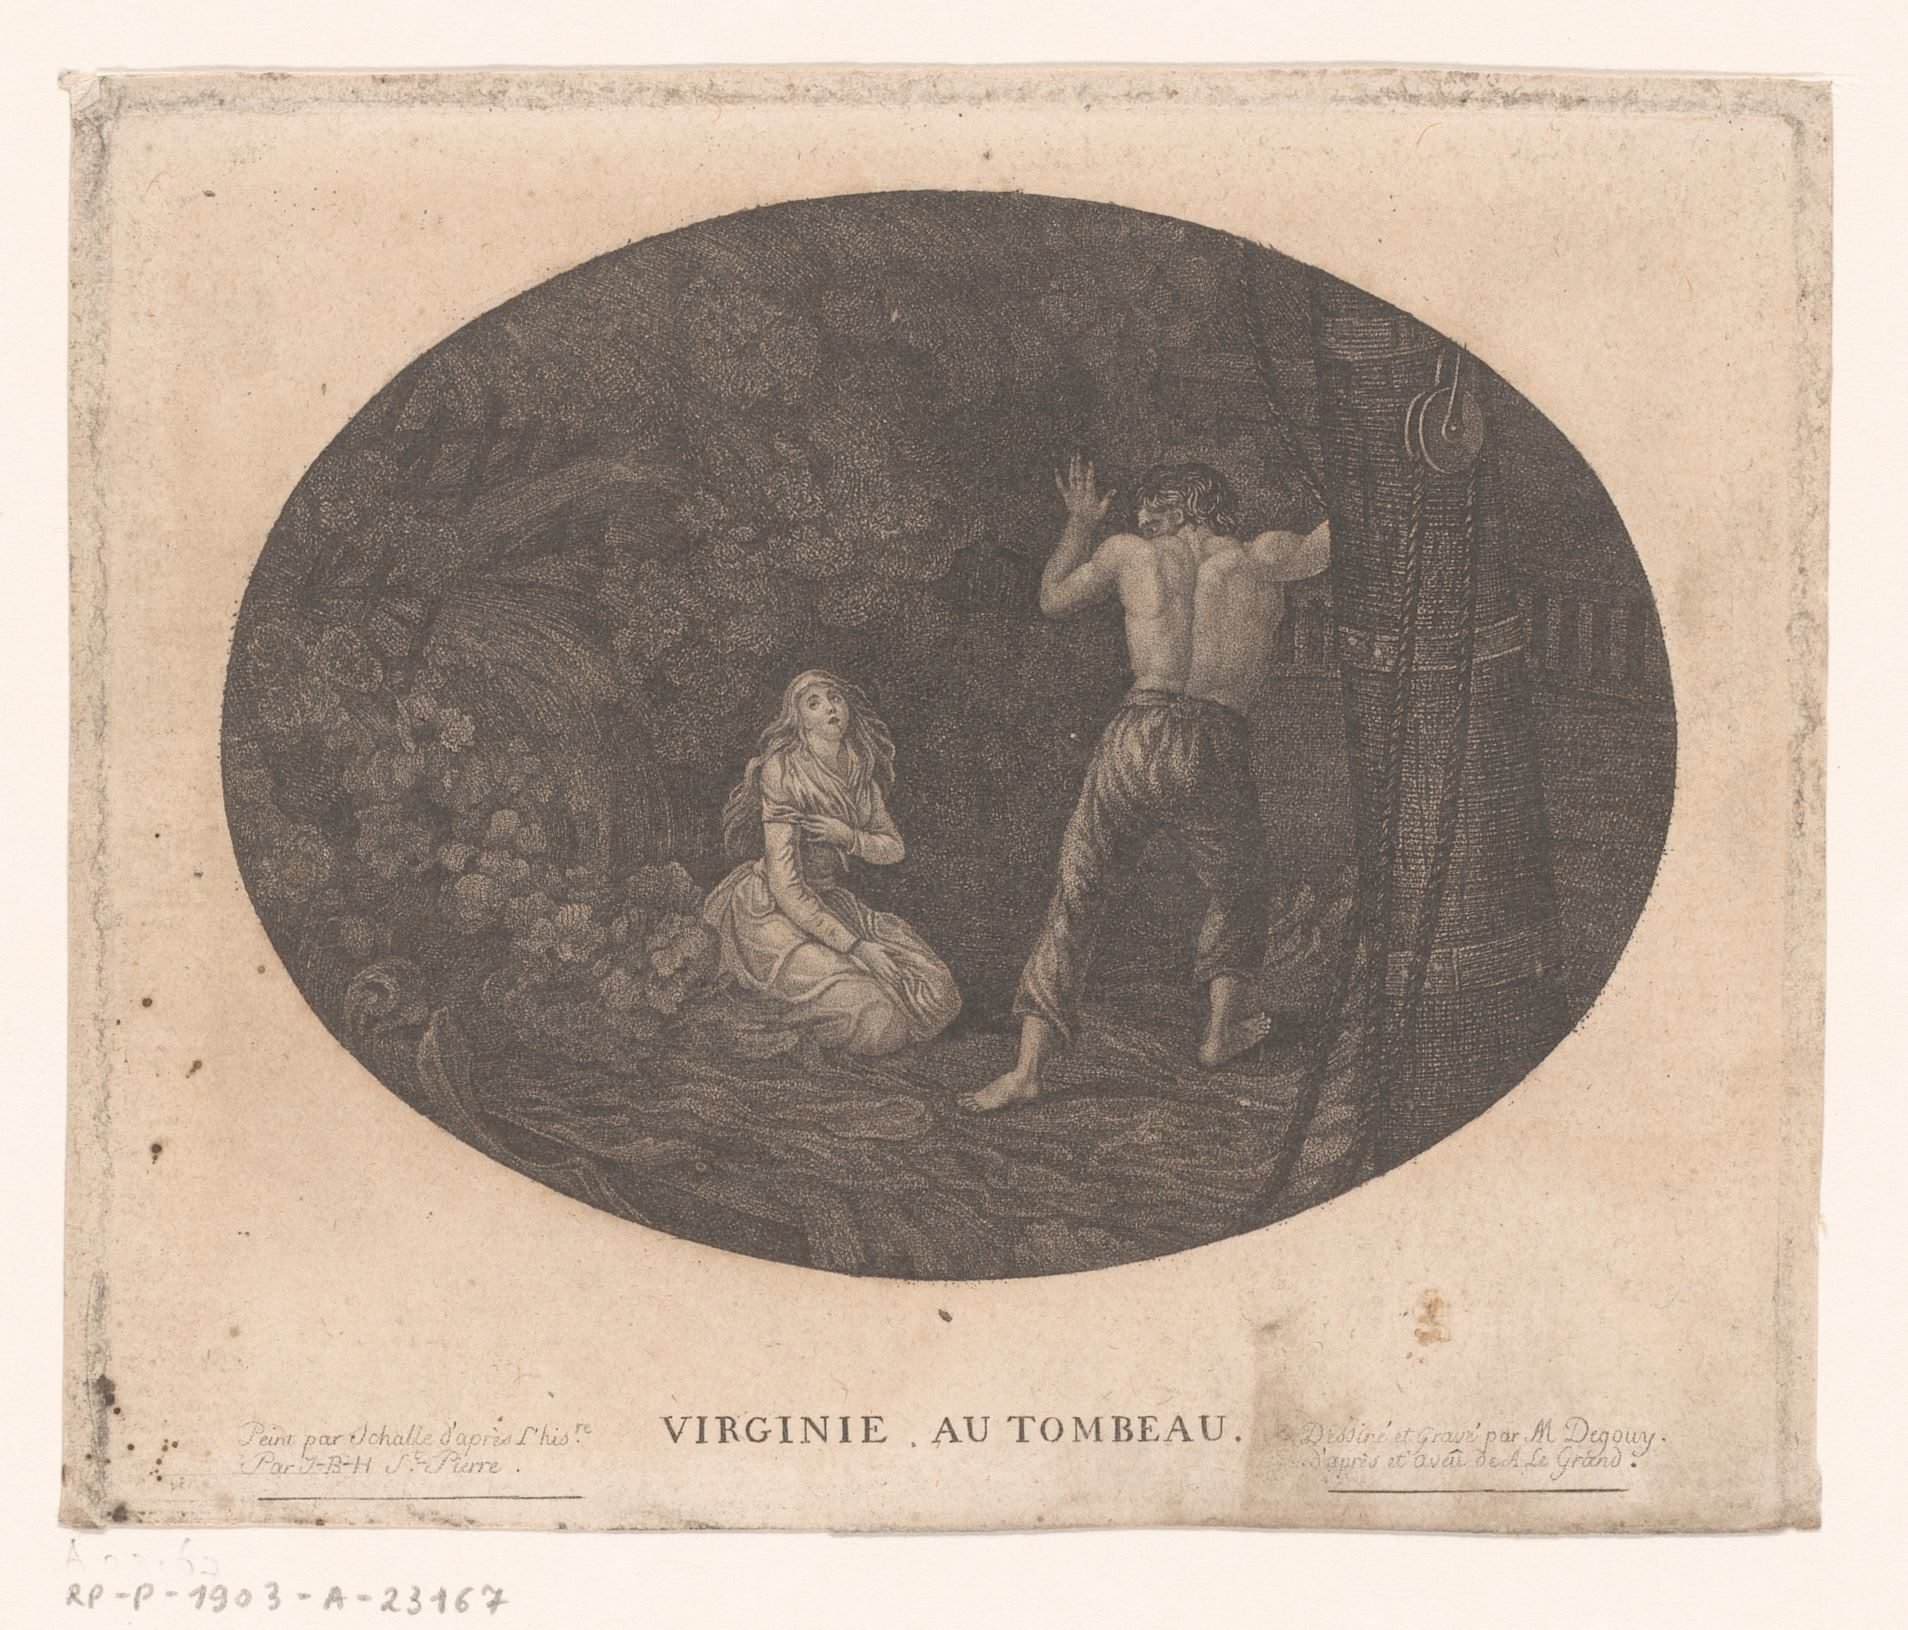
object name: print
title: Knielende vrouw voor man met ontbloot bovenlijf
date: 1770-1805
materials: paper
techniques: etching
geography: france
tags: (scenes from) specific works of literature: bernardin de saint-pierre, paul et virginie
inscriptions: collector's mark: Lugt 2228